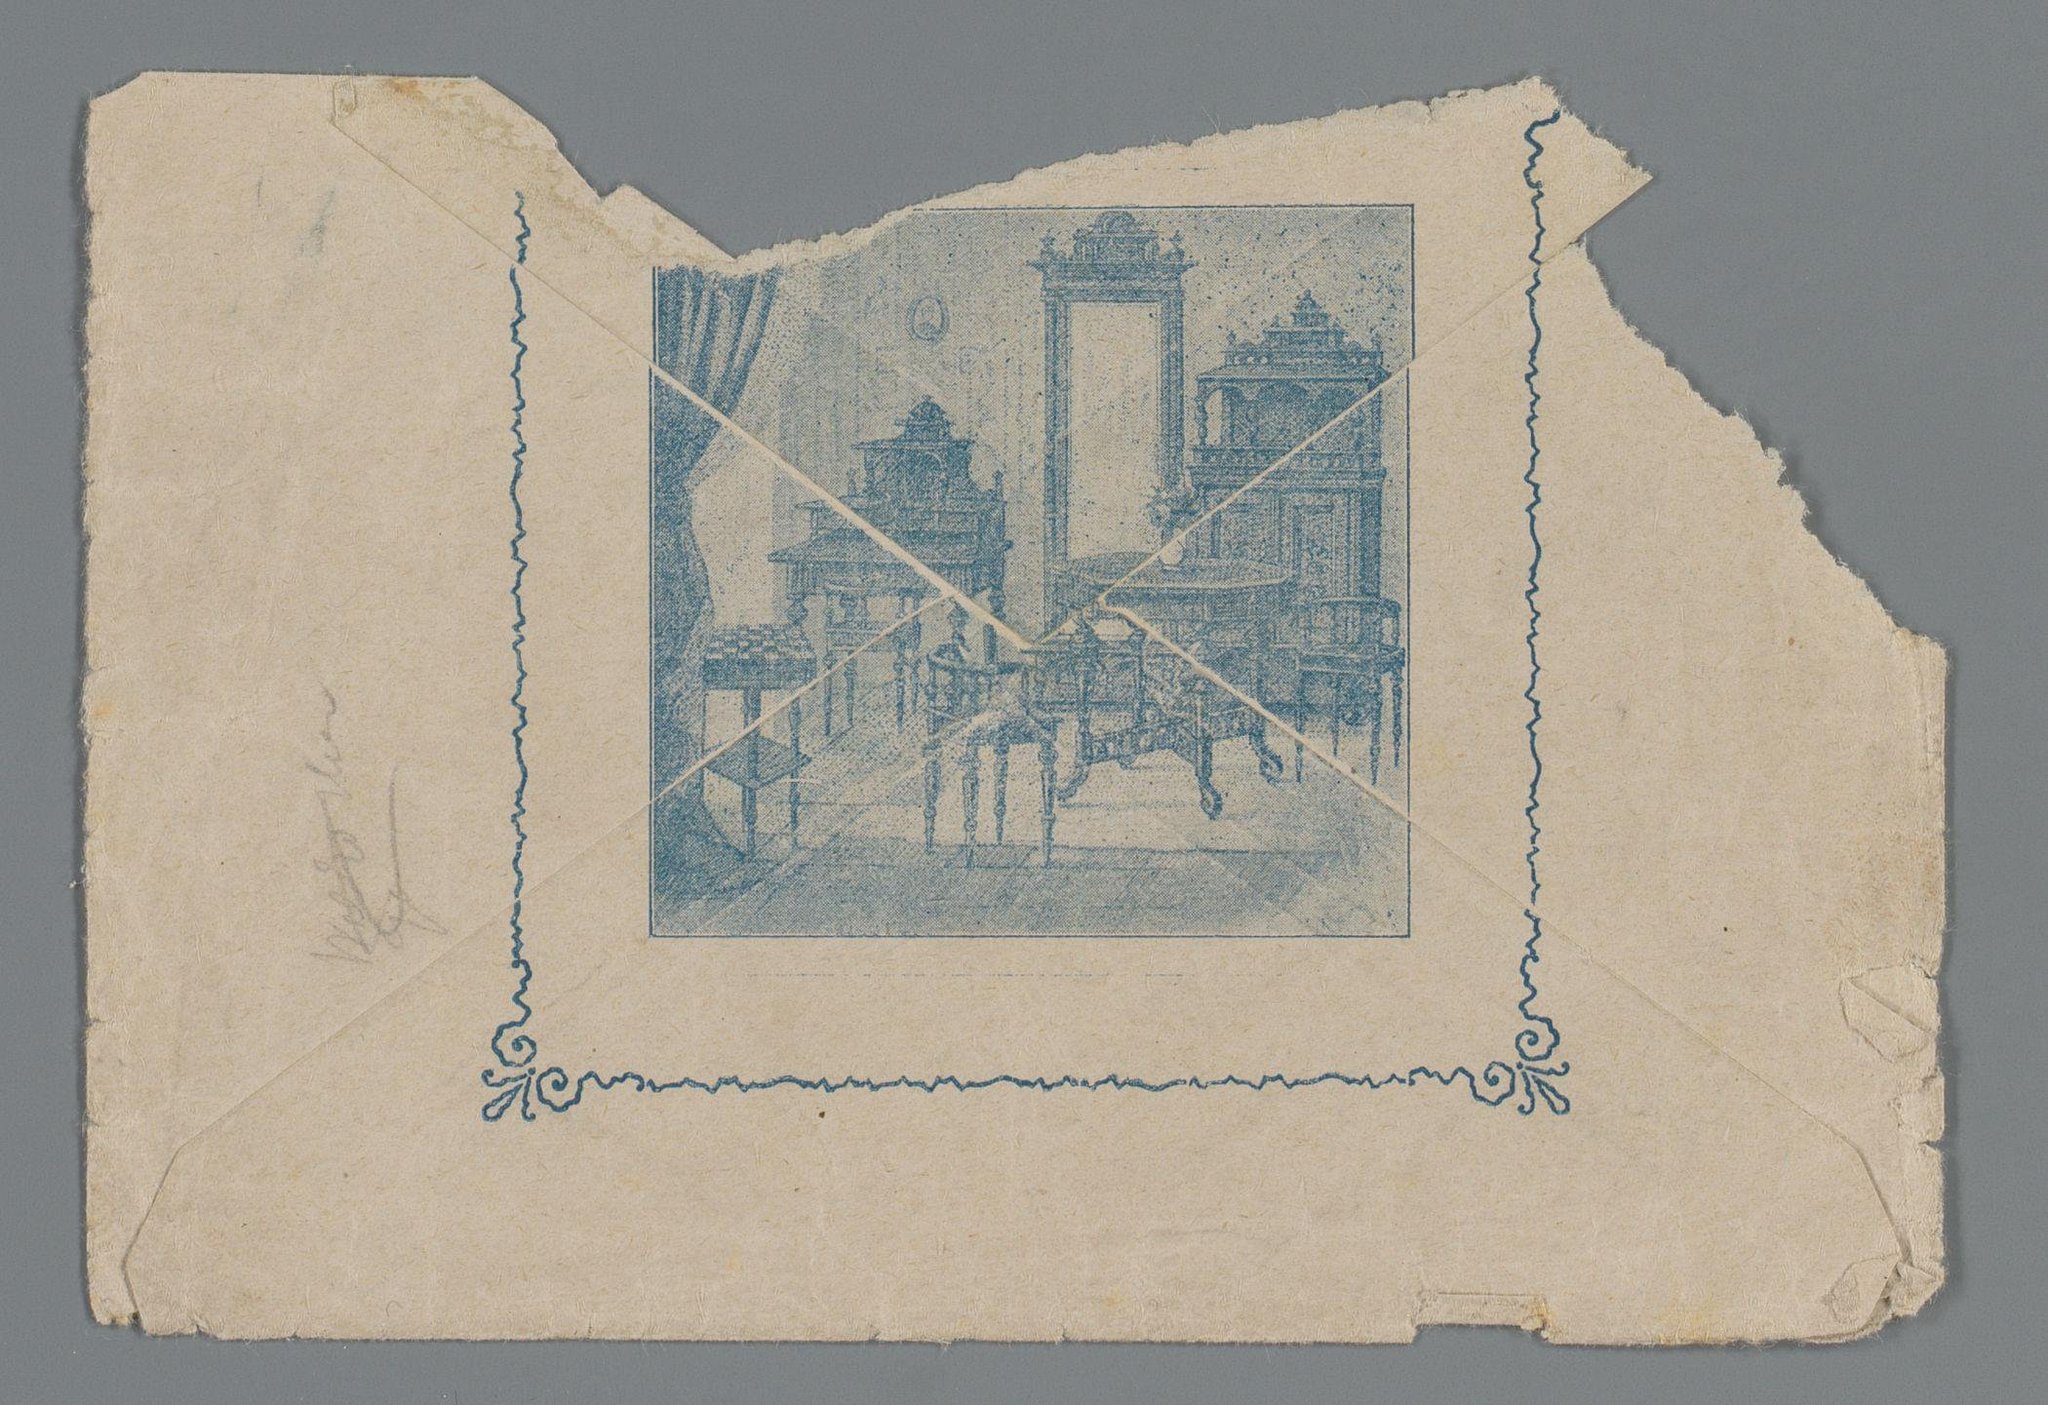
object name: envelope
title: Envelop met een afbeelding van een gemeubileerde kamer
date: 1904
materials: paper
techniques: autotype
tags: furniture and household effects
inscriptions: inscription: ‘[...] Heer/ G. v.d. Wall Perné/ Wilhelminastraat 19./ Stad’